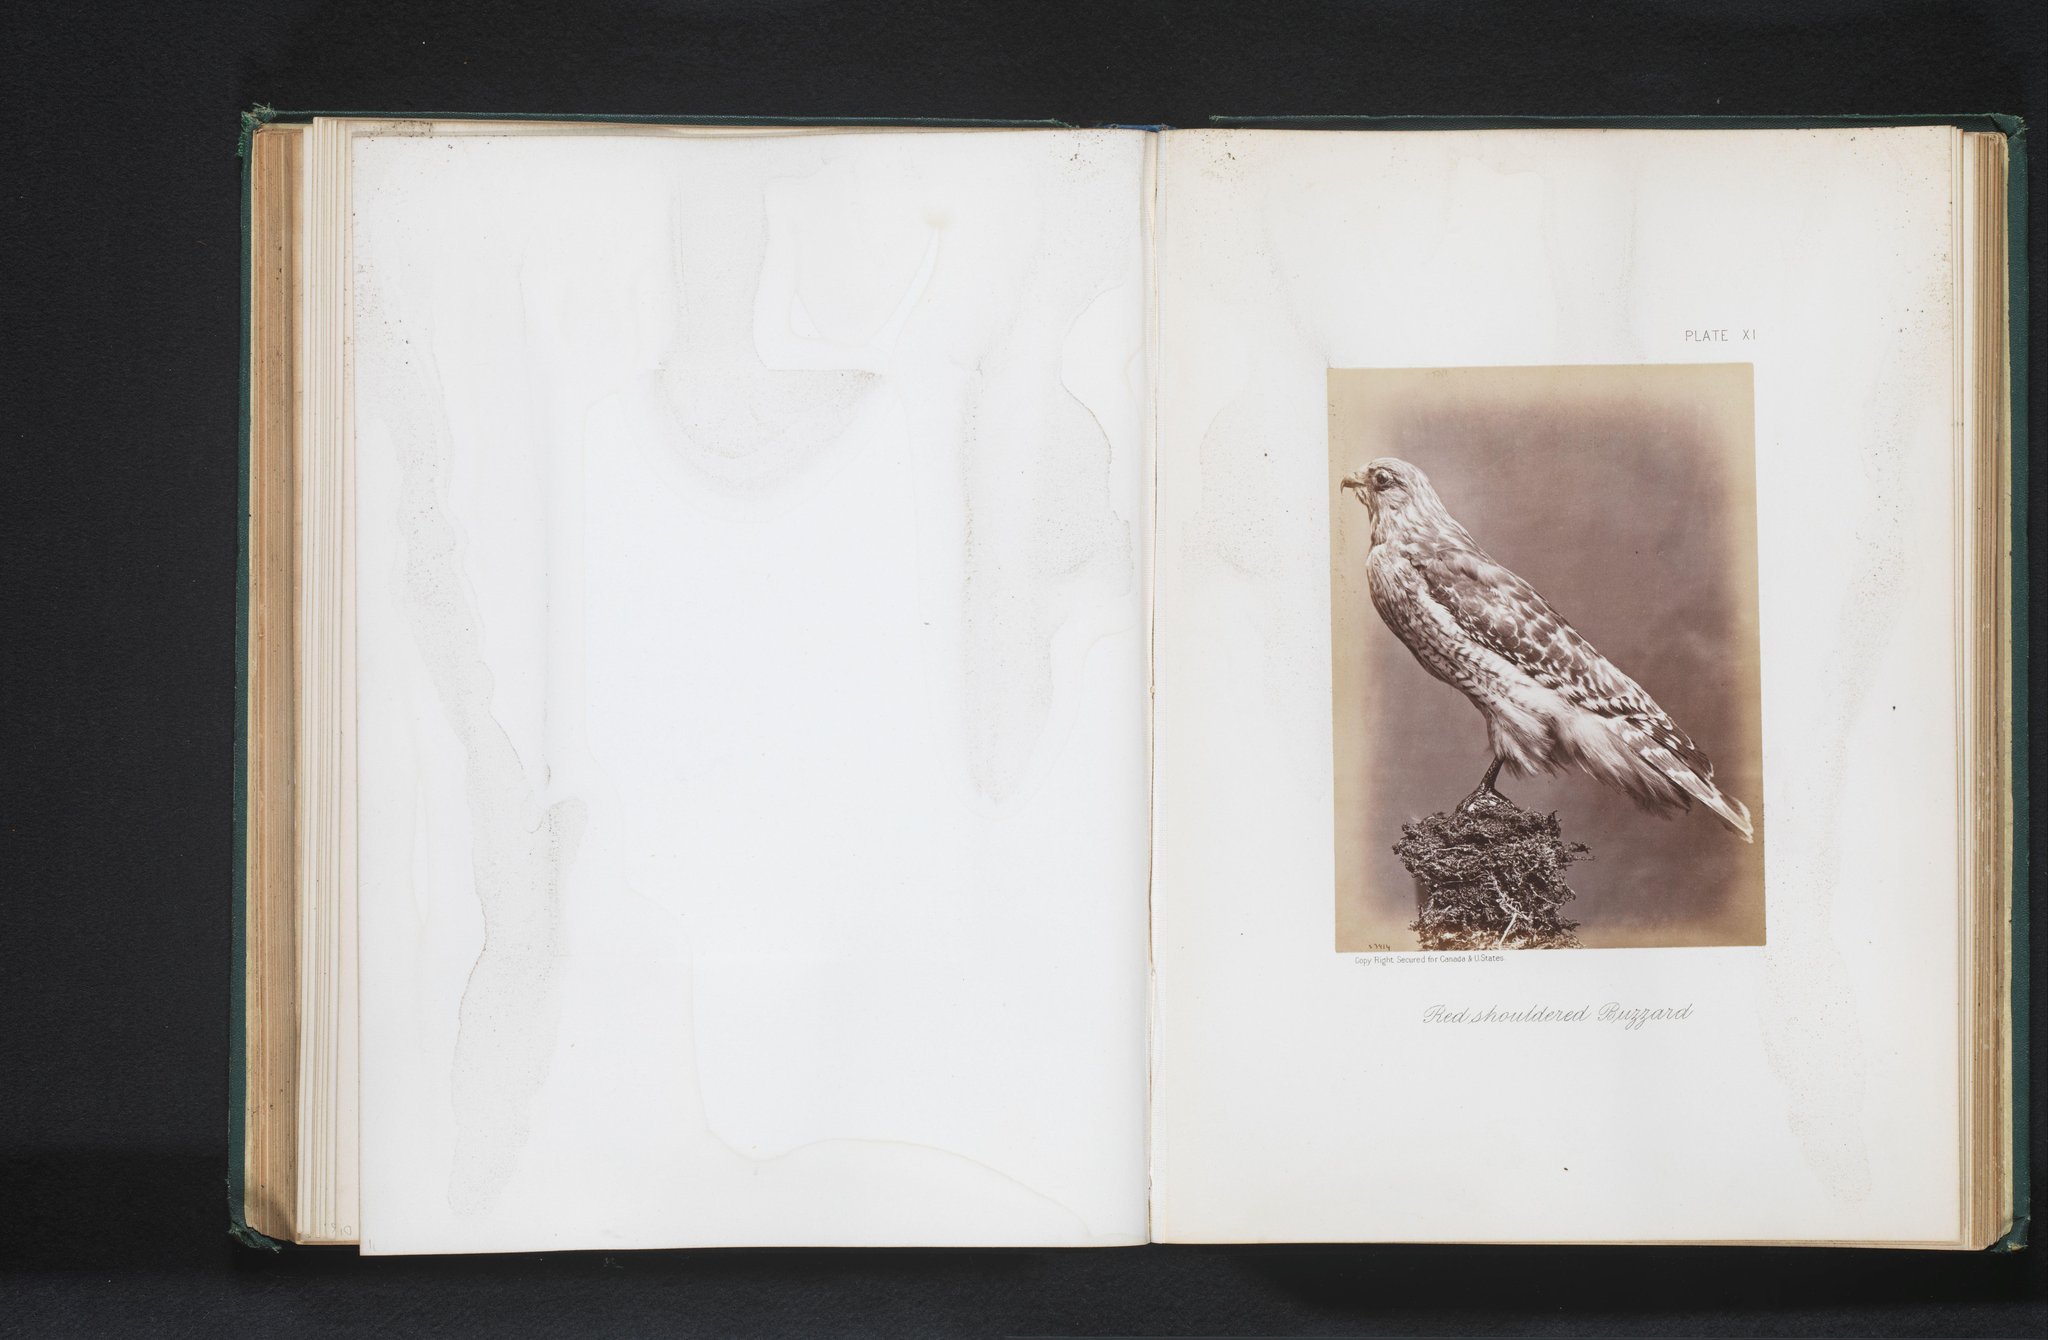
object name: photograph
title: Redshouldered Buzzard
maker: william notman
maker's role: fotograaf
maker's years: 1826-1891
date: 1871-1876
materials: paper, photographic support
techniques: albumen print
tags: collection of animals, predatory birds: buzzard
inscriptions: number: ‘PLATE XI’, inscription: ‘Copy Right Secured for Canada & U.States’